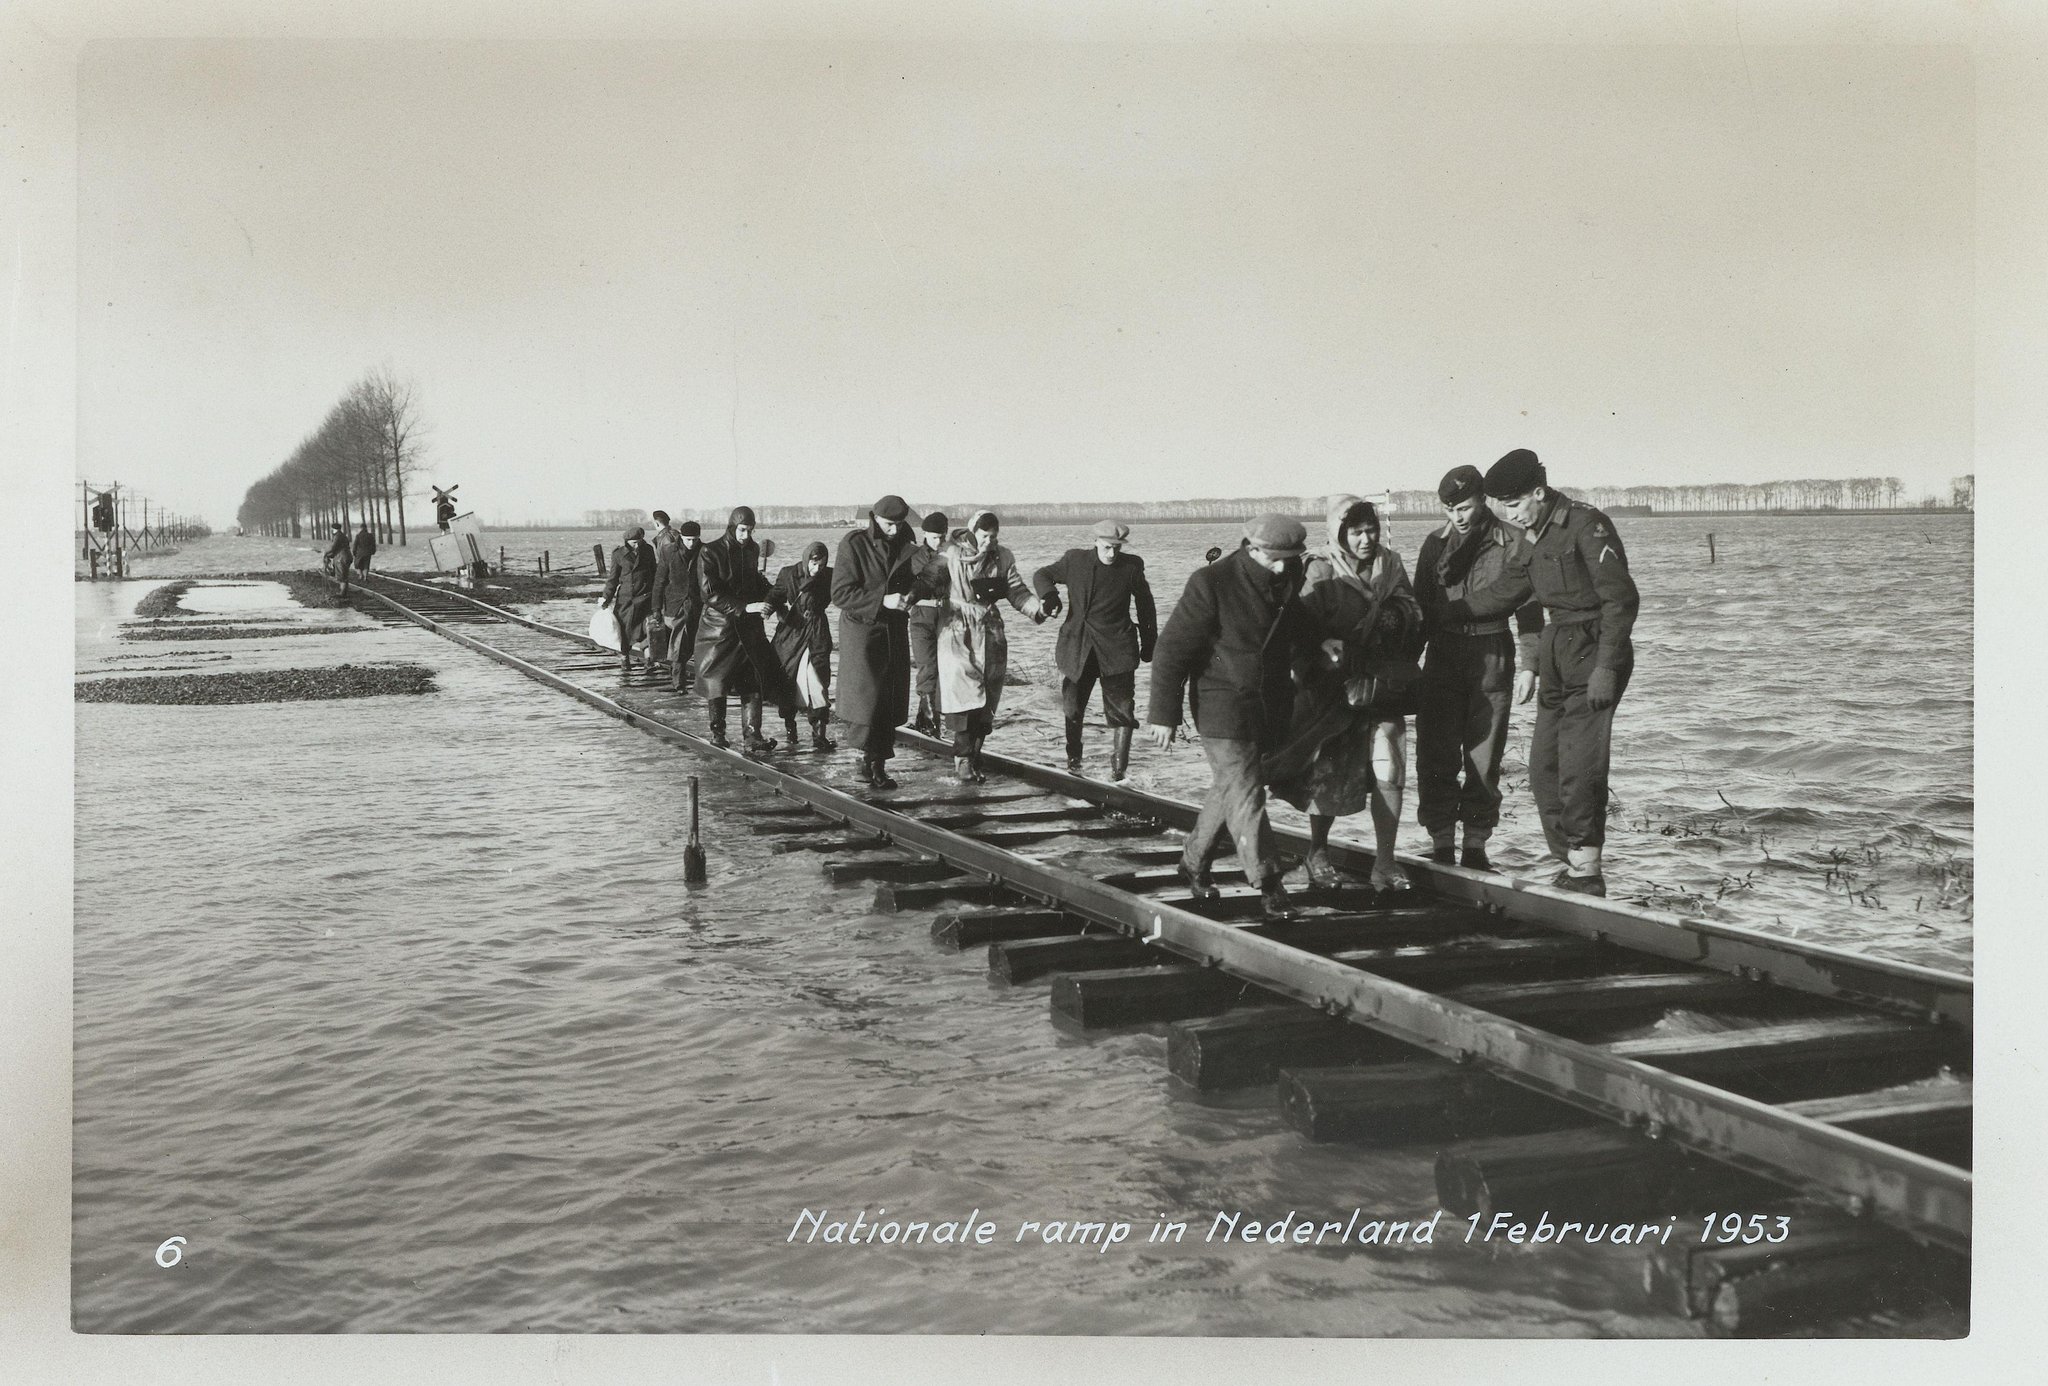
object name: photograph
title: Nationale ramp in Nederland 1 februari 1953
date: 1902-1953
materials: photographic support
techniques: photography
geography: zeeland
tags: zeeland, north sea flood of 1953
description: Militairen brengen burgers in veiligheid over overstroomde spoorrails in een ondergelopen deel van Zeeland.